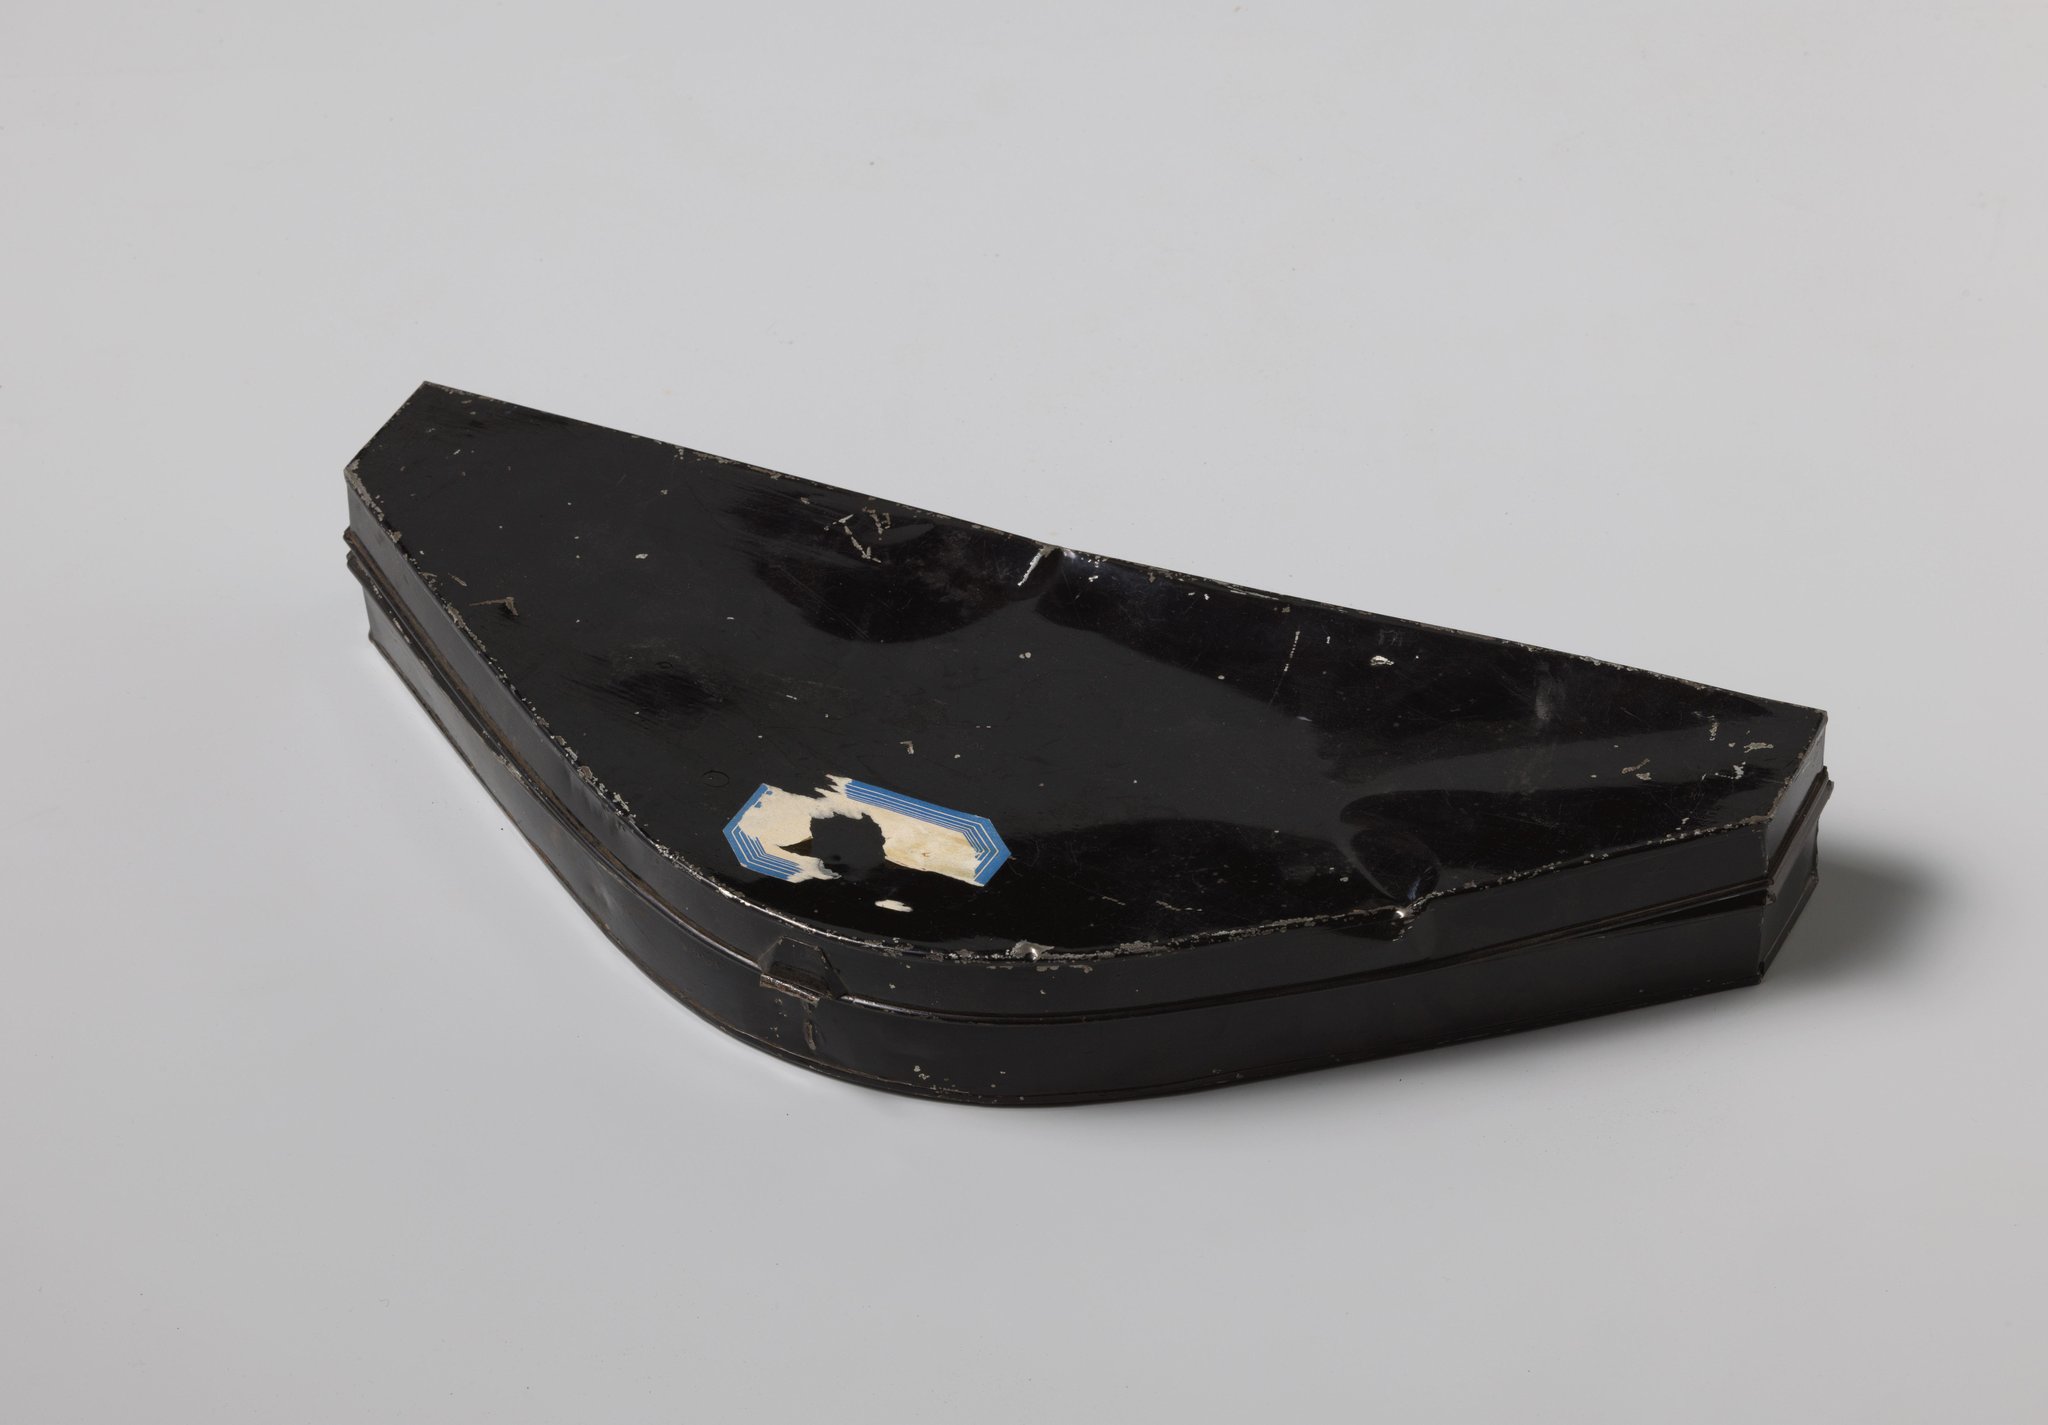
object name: tin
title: Blikken trommel behorende bij steek van ambassadeur A.H.J. Lovink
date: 1948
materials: metal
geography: the hague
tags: the hague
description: De heer Lovink heeft in deze tijd het kostuum laten maken toen hij Secretaris-Generaal van het Ministerie van Buitenlandse Zaken was. Nadien werd het kostuum gebruikt voor zijn ambt als ambassadeur.